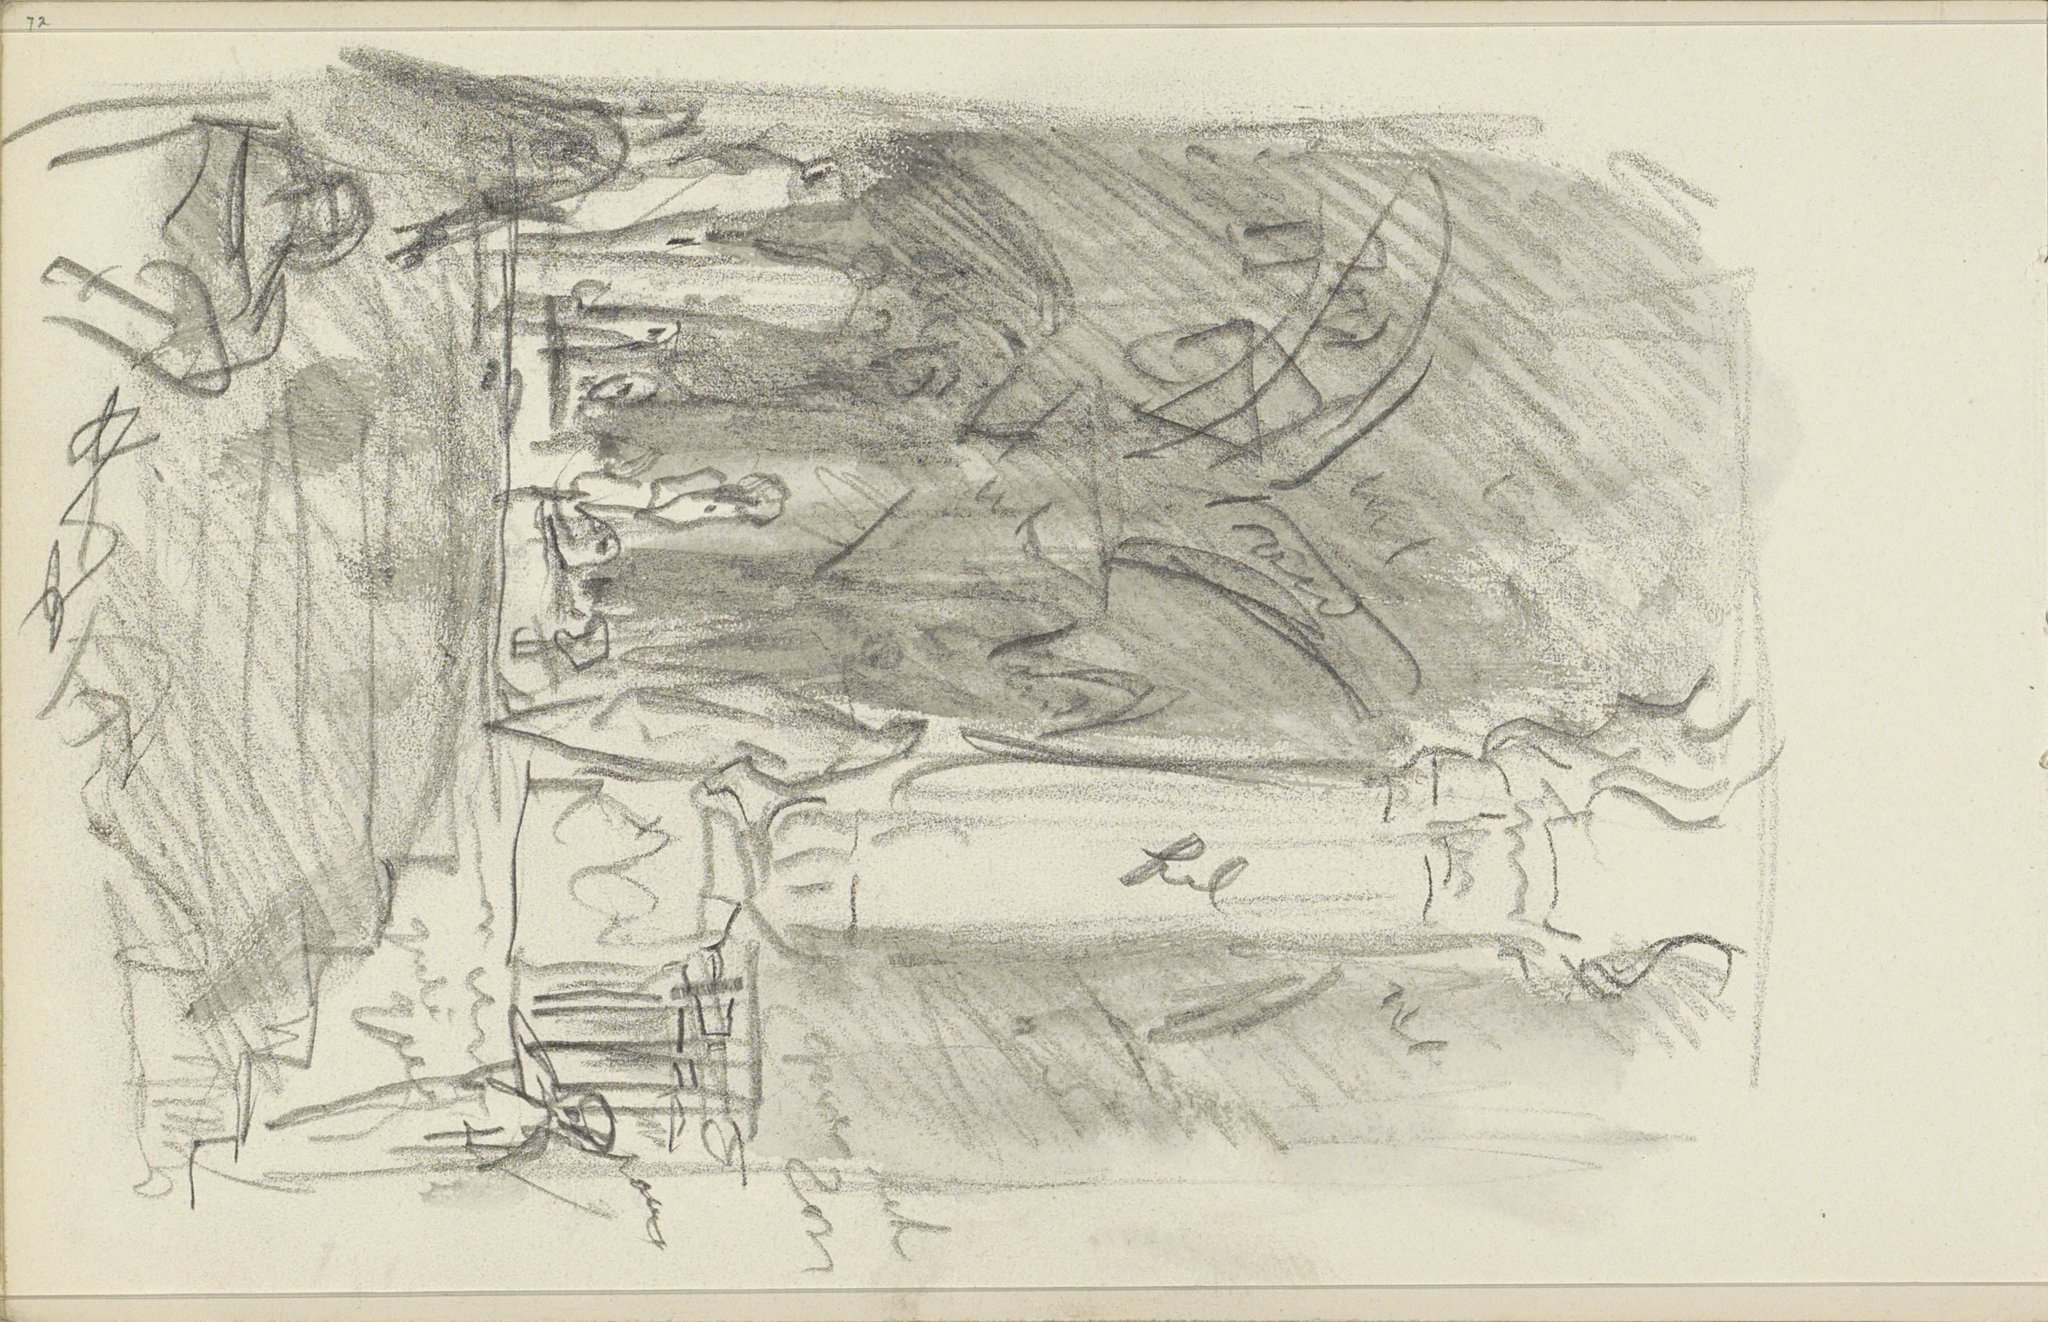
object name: sketchbook leaf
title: Zuil bovenaan een tempeltrap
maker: marius bauer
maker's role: draughtsman, print maker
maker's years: 1867-1932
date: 1924-1925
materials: chalk, paper, pencil, watercolor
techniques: brush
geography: india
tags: temple, shrine ~ hinduism, buddhism, jainism, flight of steps, column, pillar ~ architecture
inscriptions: kleurnotitie, handgeschreven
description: Pagina 72 uit een schetsboek met 48 bladen.